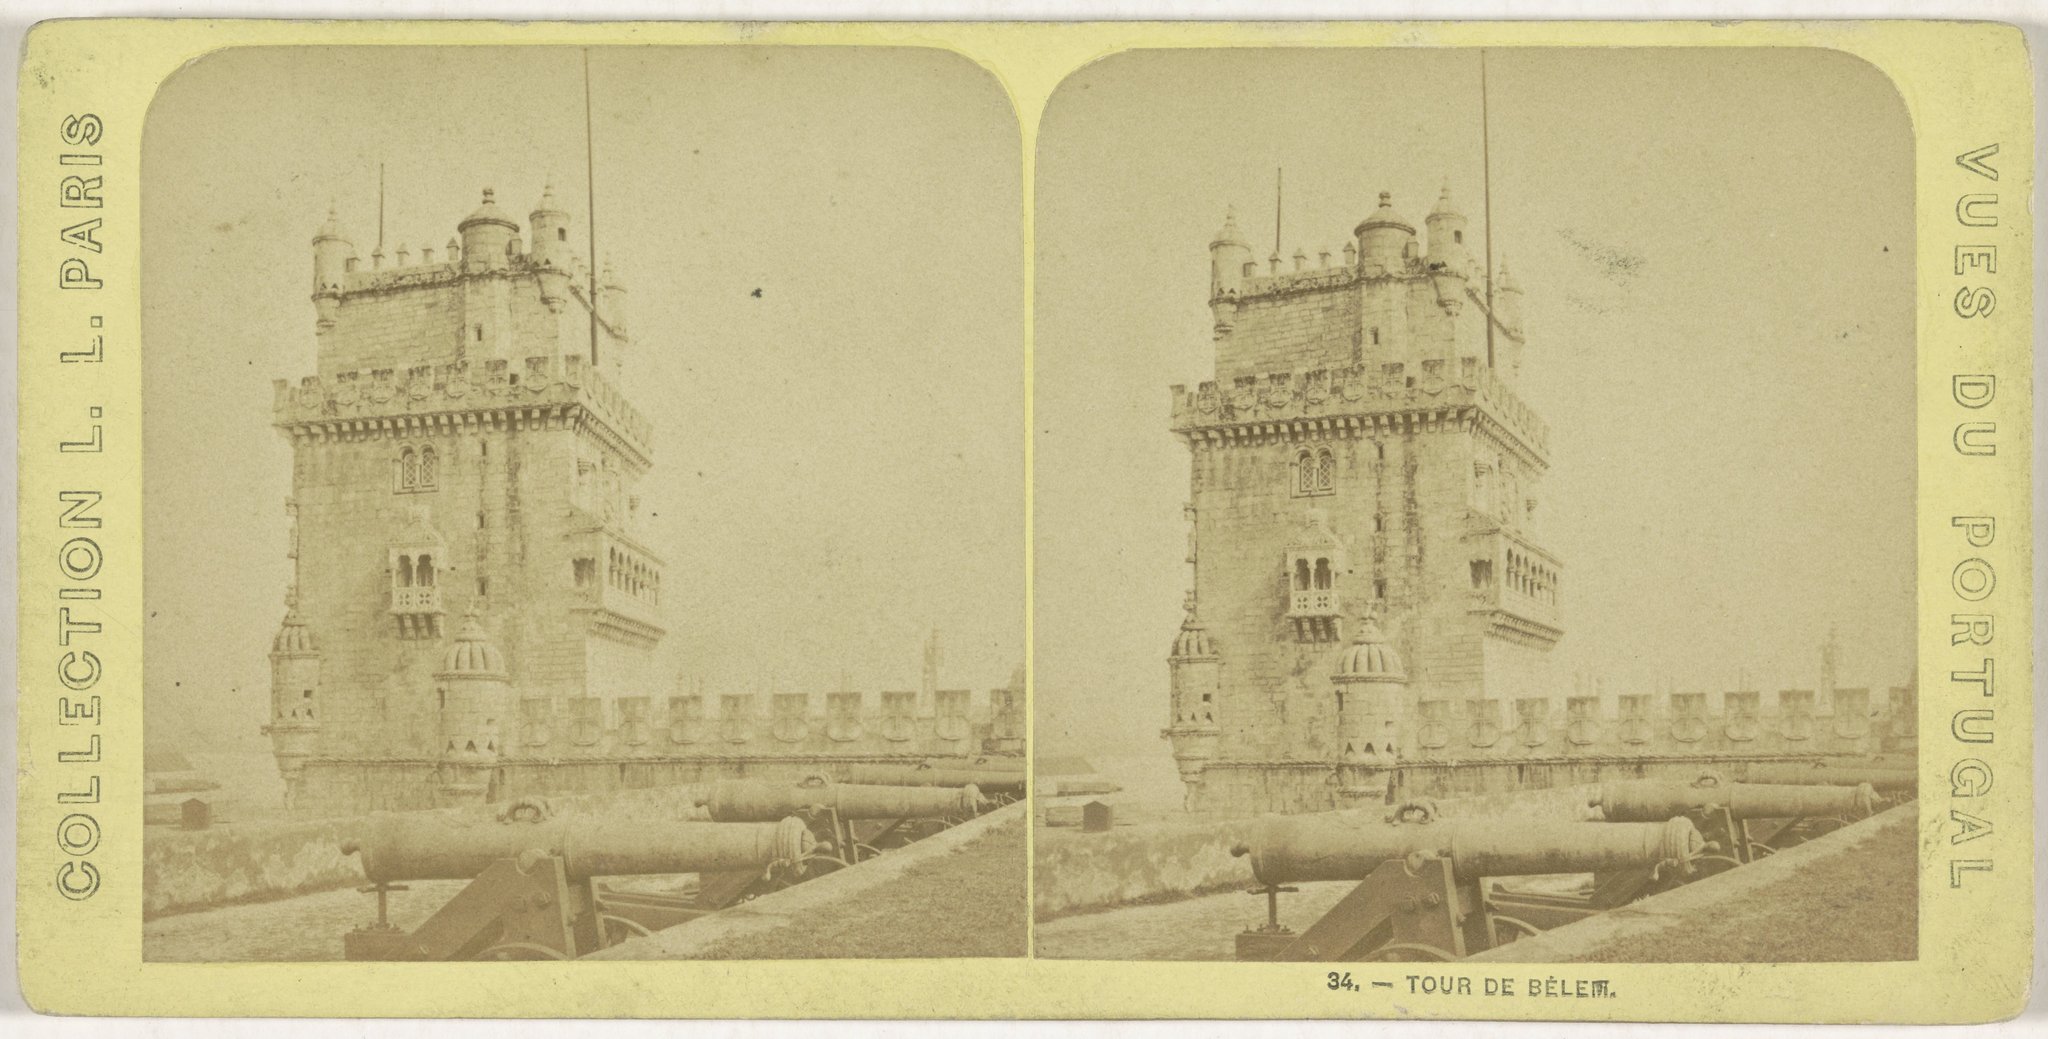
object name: stereograph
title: Tour de Bélem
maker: Anonymous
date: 1868-1890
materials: cardboard, paper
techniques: albumen print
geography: paris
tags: towers ~ fortified city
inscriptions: number: ‘34.’